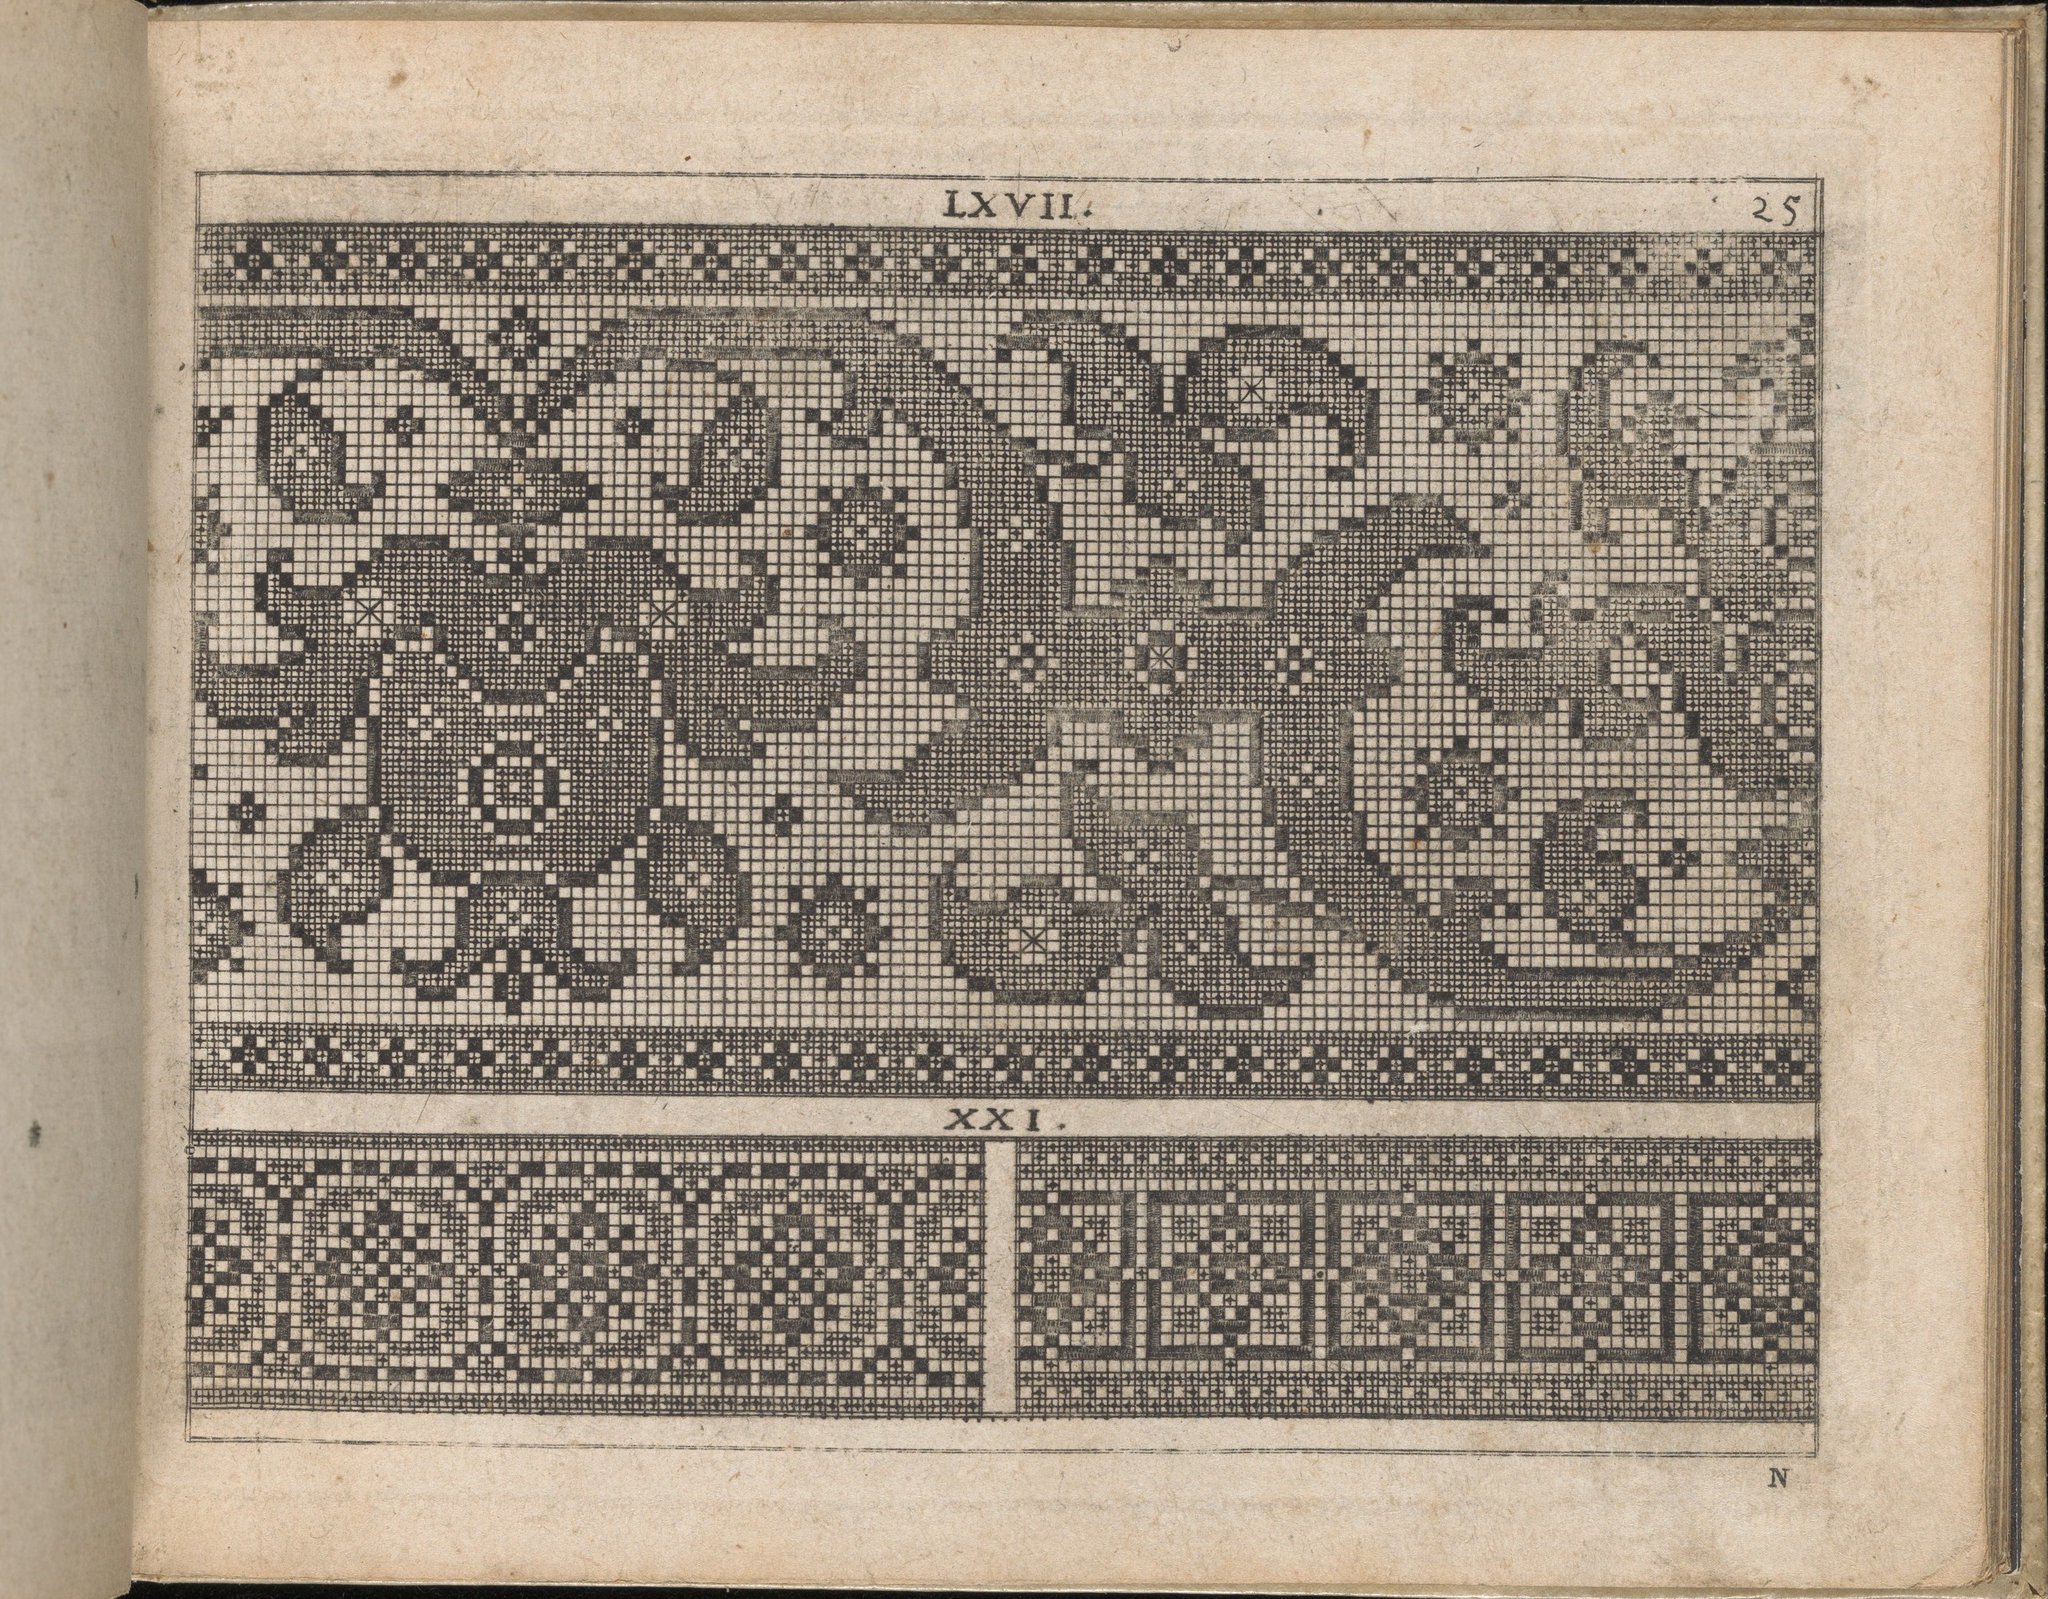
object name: book print ornament architecture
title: Newes Modelbuch in Kupffer (Page 34r)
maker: johann sibmacher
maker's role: artist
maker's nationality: german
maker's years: 1590-1611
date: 1604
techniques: etching